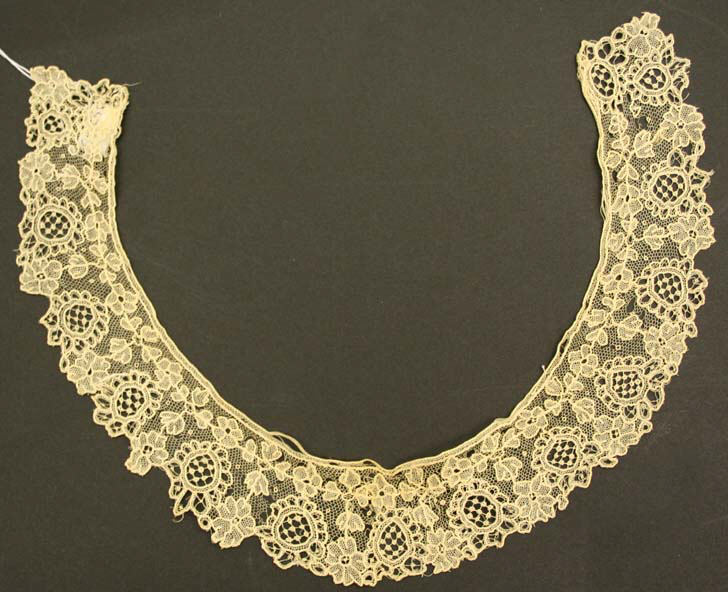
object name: collar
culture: european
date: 1861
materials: cotton